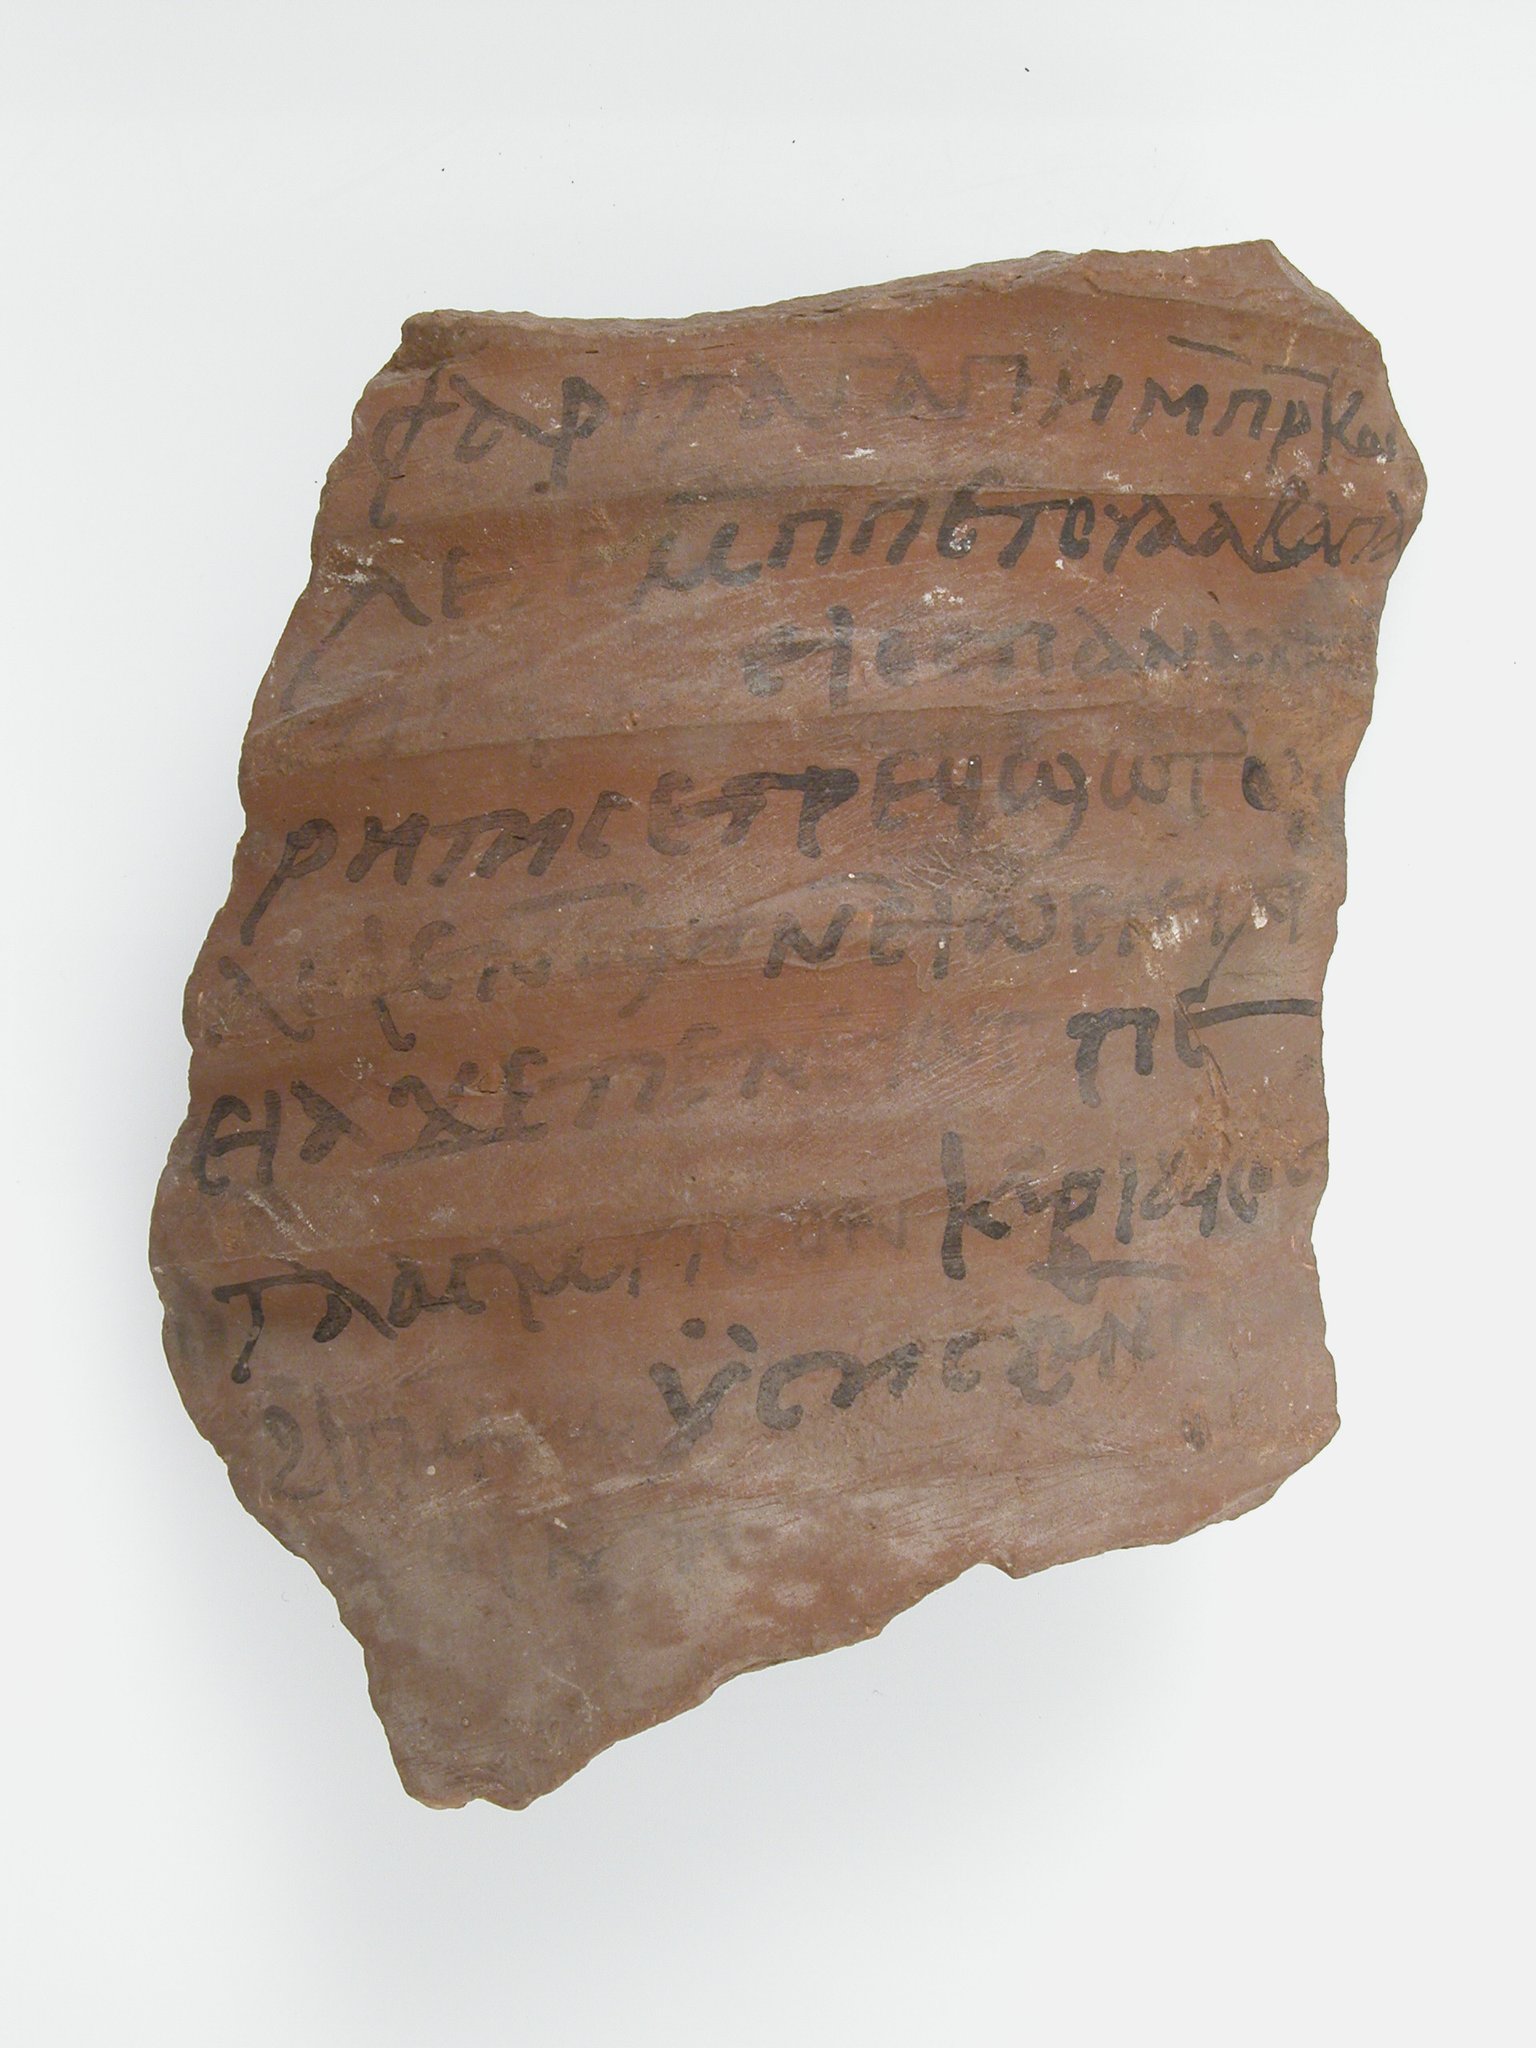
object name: ostrakon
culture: coptic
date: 601-700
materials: ink, pottery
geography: egypt